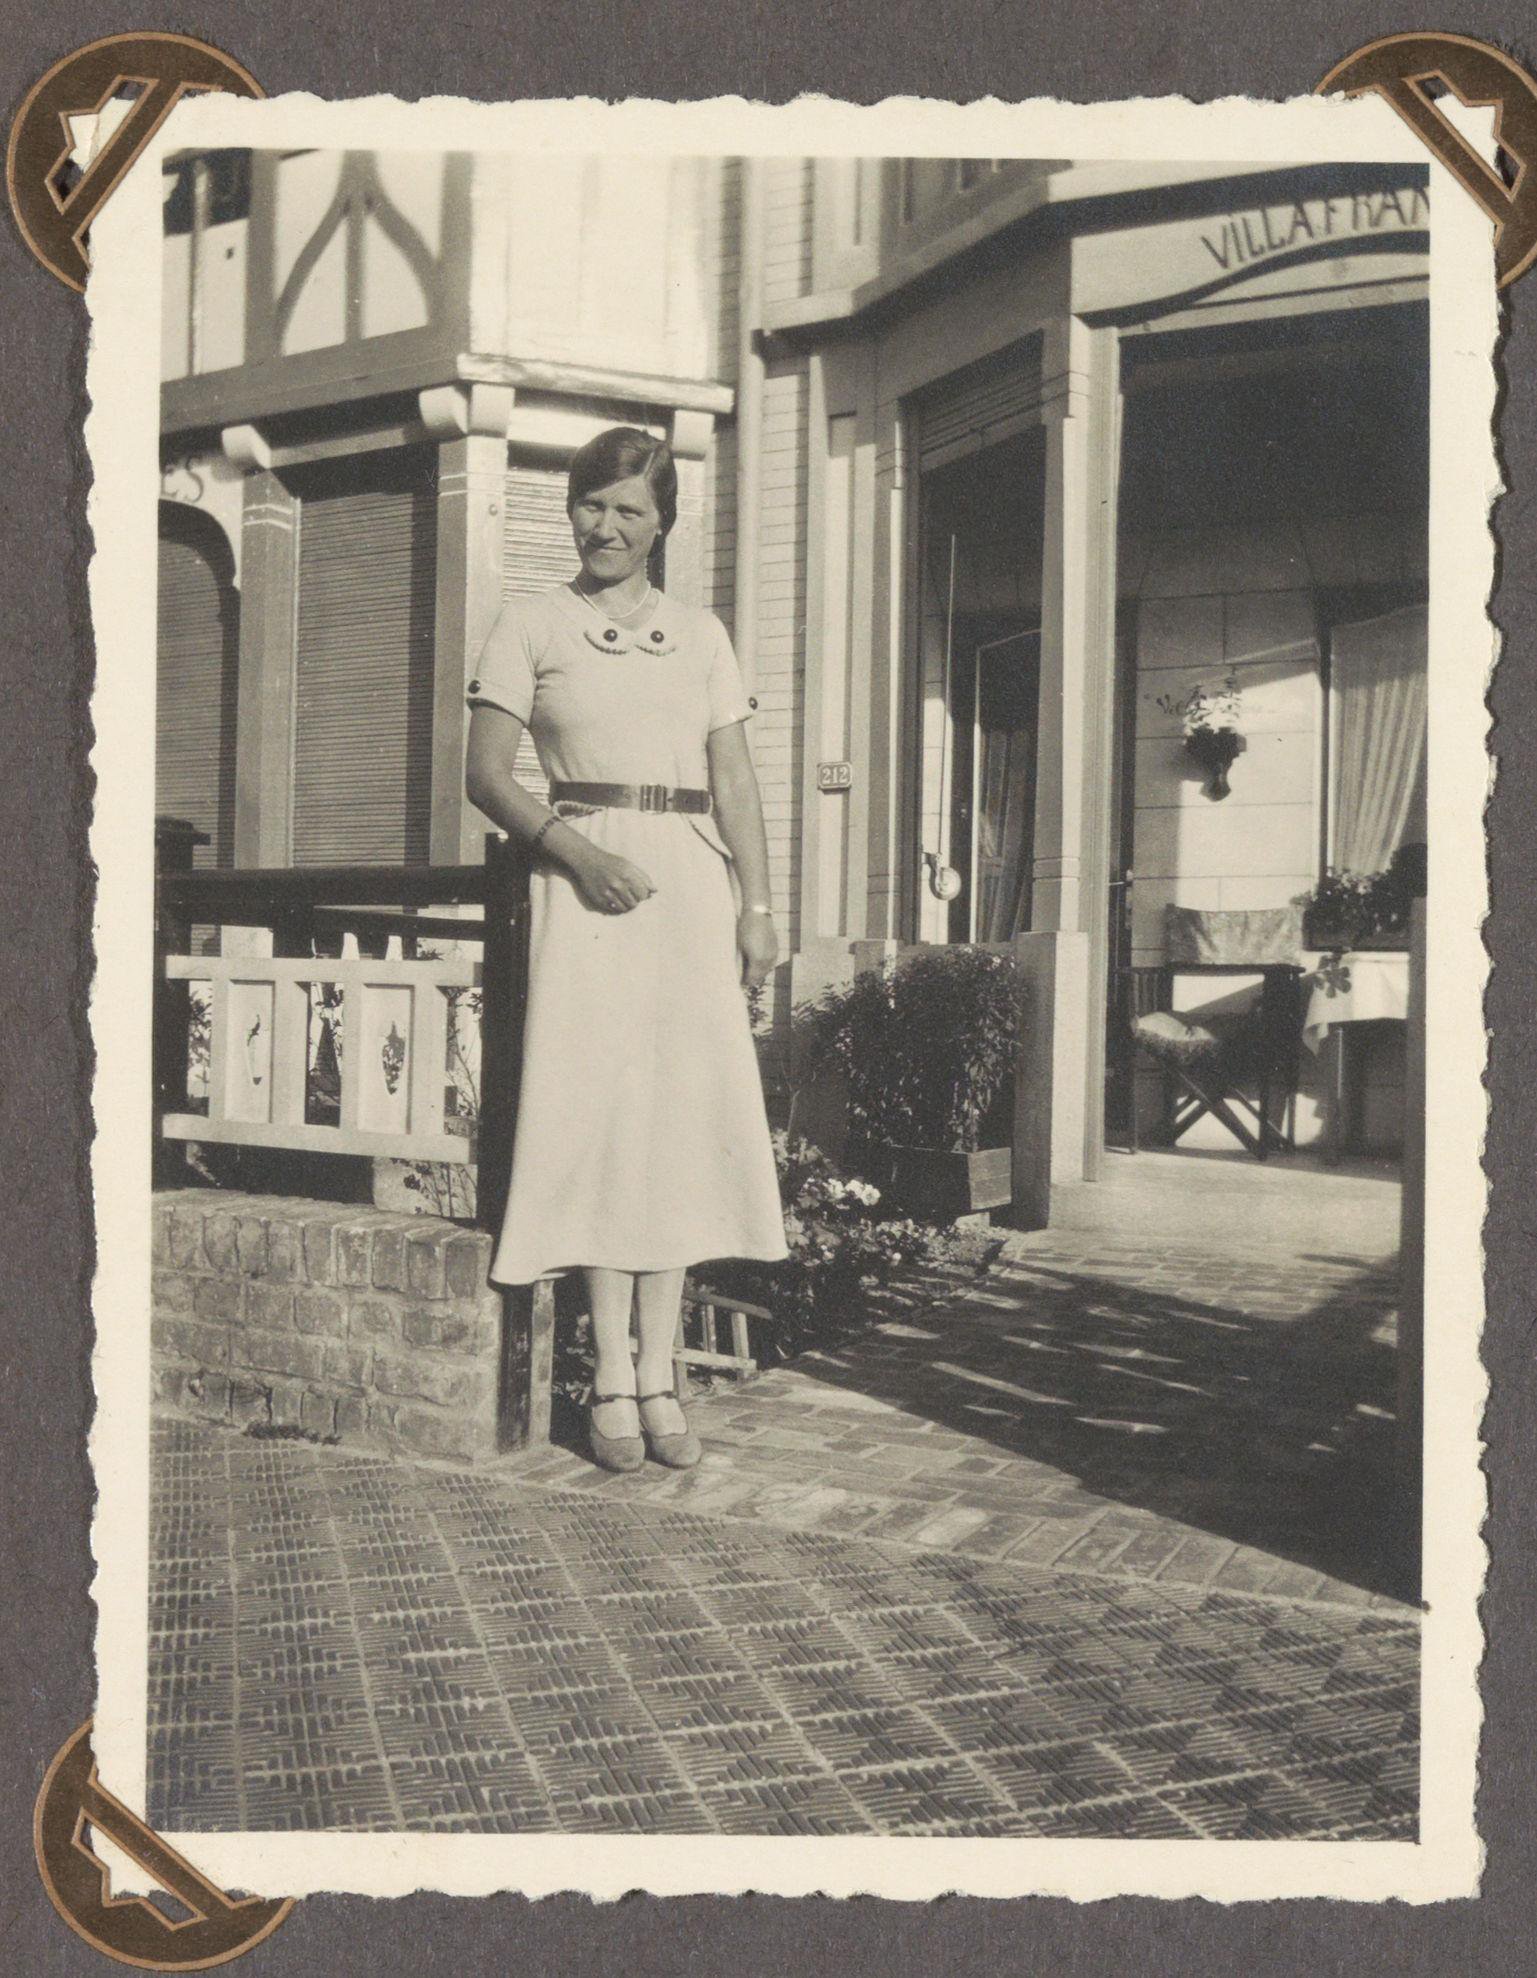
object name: photograph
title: Vrouw staand voor een villa, vermoedelijk in Zuid-Frankrijk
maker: Anonymous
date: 1930-1935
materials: photographic support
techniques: gelatin silver print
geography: southern france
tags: adult woman, rural housing, e.g. country-house, villa, cottage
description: Onderdeel van Fotoalbum met opnames van vakanties in Zuid-Frankrijk.